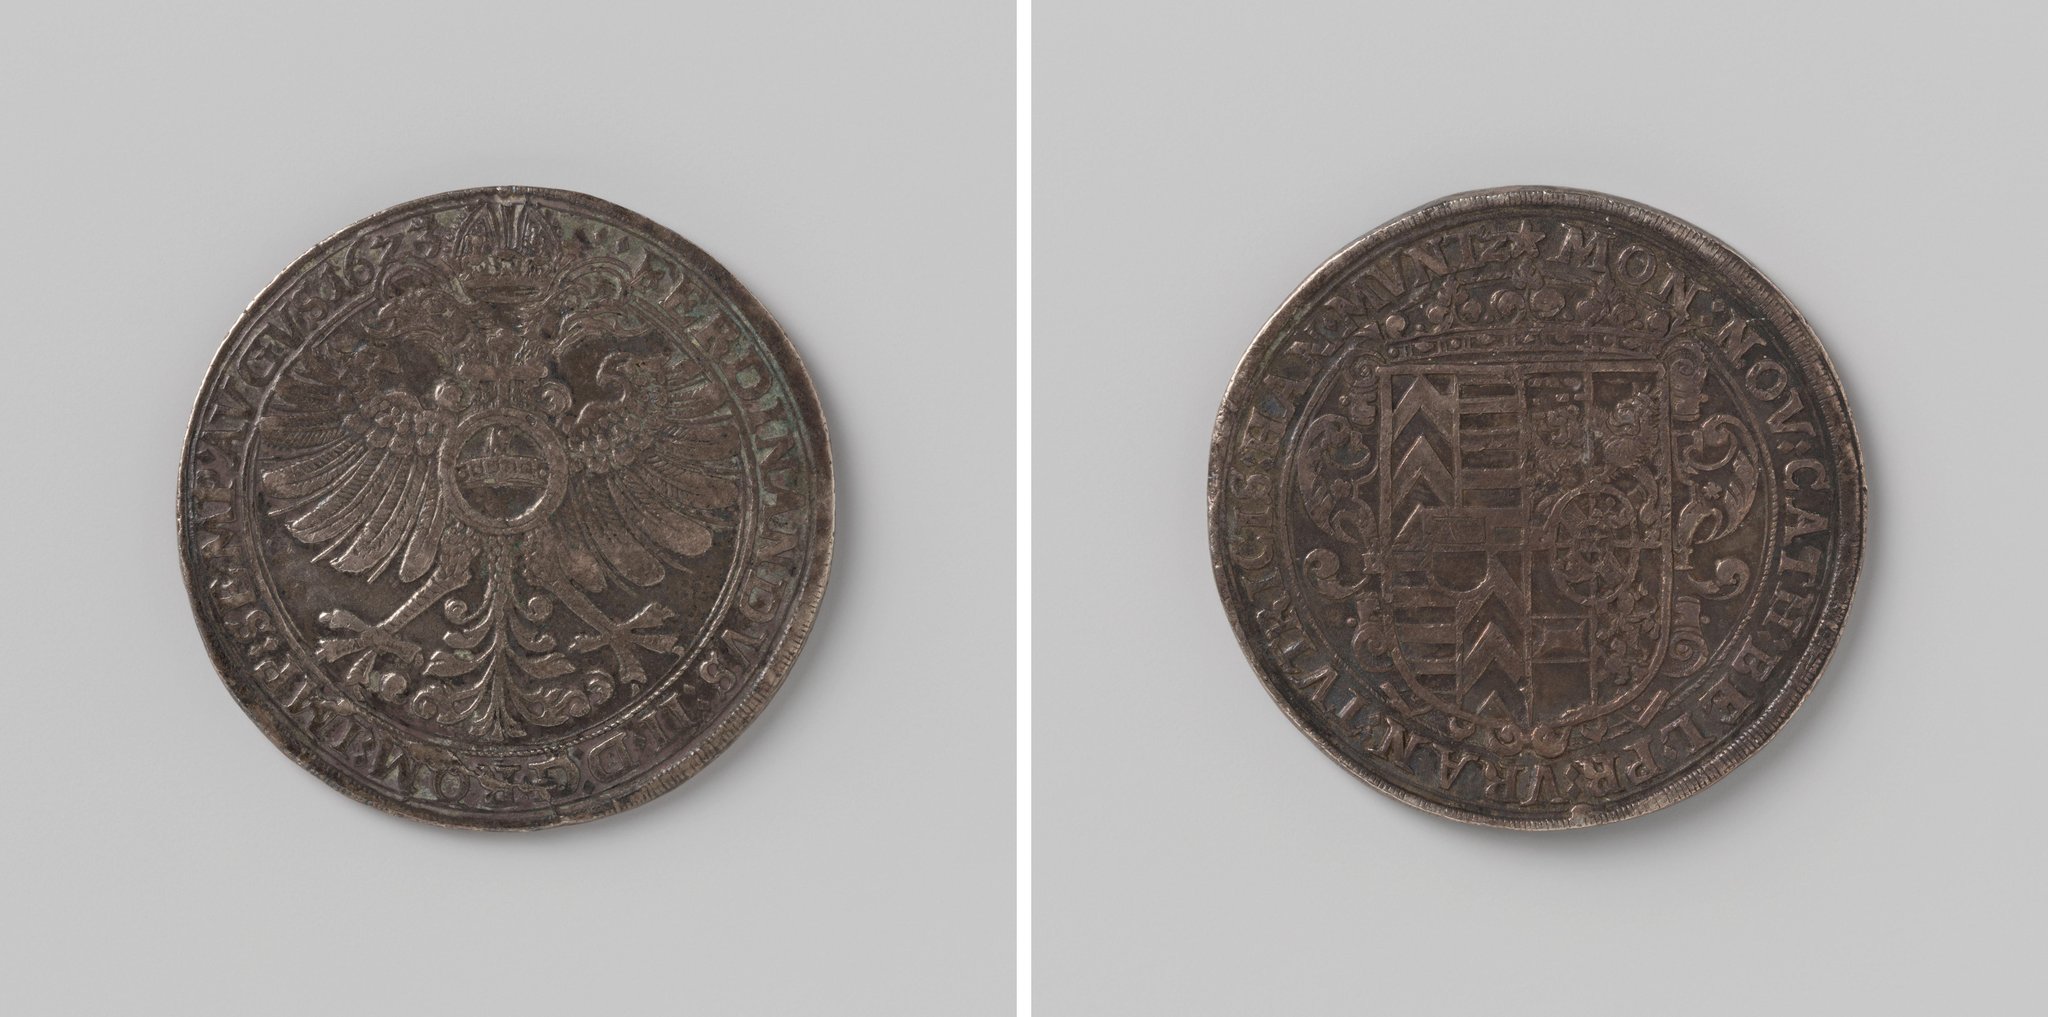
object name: taler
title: Taler uit Hanau-Münzenberg van Catherina van Oranje, dochter van prins Willem I en regent van Hanau-Münzenberg (1612-1626) voor haar zoon Philips Maurits (1612-1638)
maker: Anonymous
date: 1623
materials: silver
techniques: striking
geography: babenhausen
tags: philips maurits, gravin, catharina belgica (gravin van nassau en hanau-münzenberg)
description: Zilveren munt, taler. Voorzijde: tweekoppige adelaar onder kroon binnen omschrift. Keerzijde: wapenschild binnen omschrift.